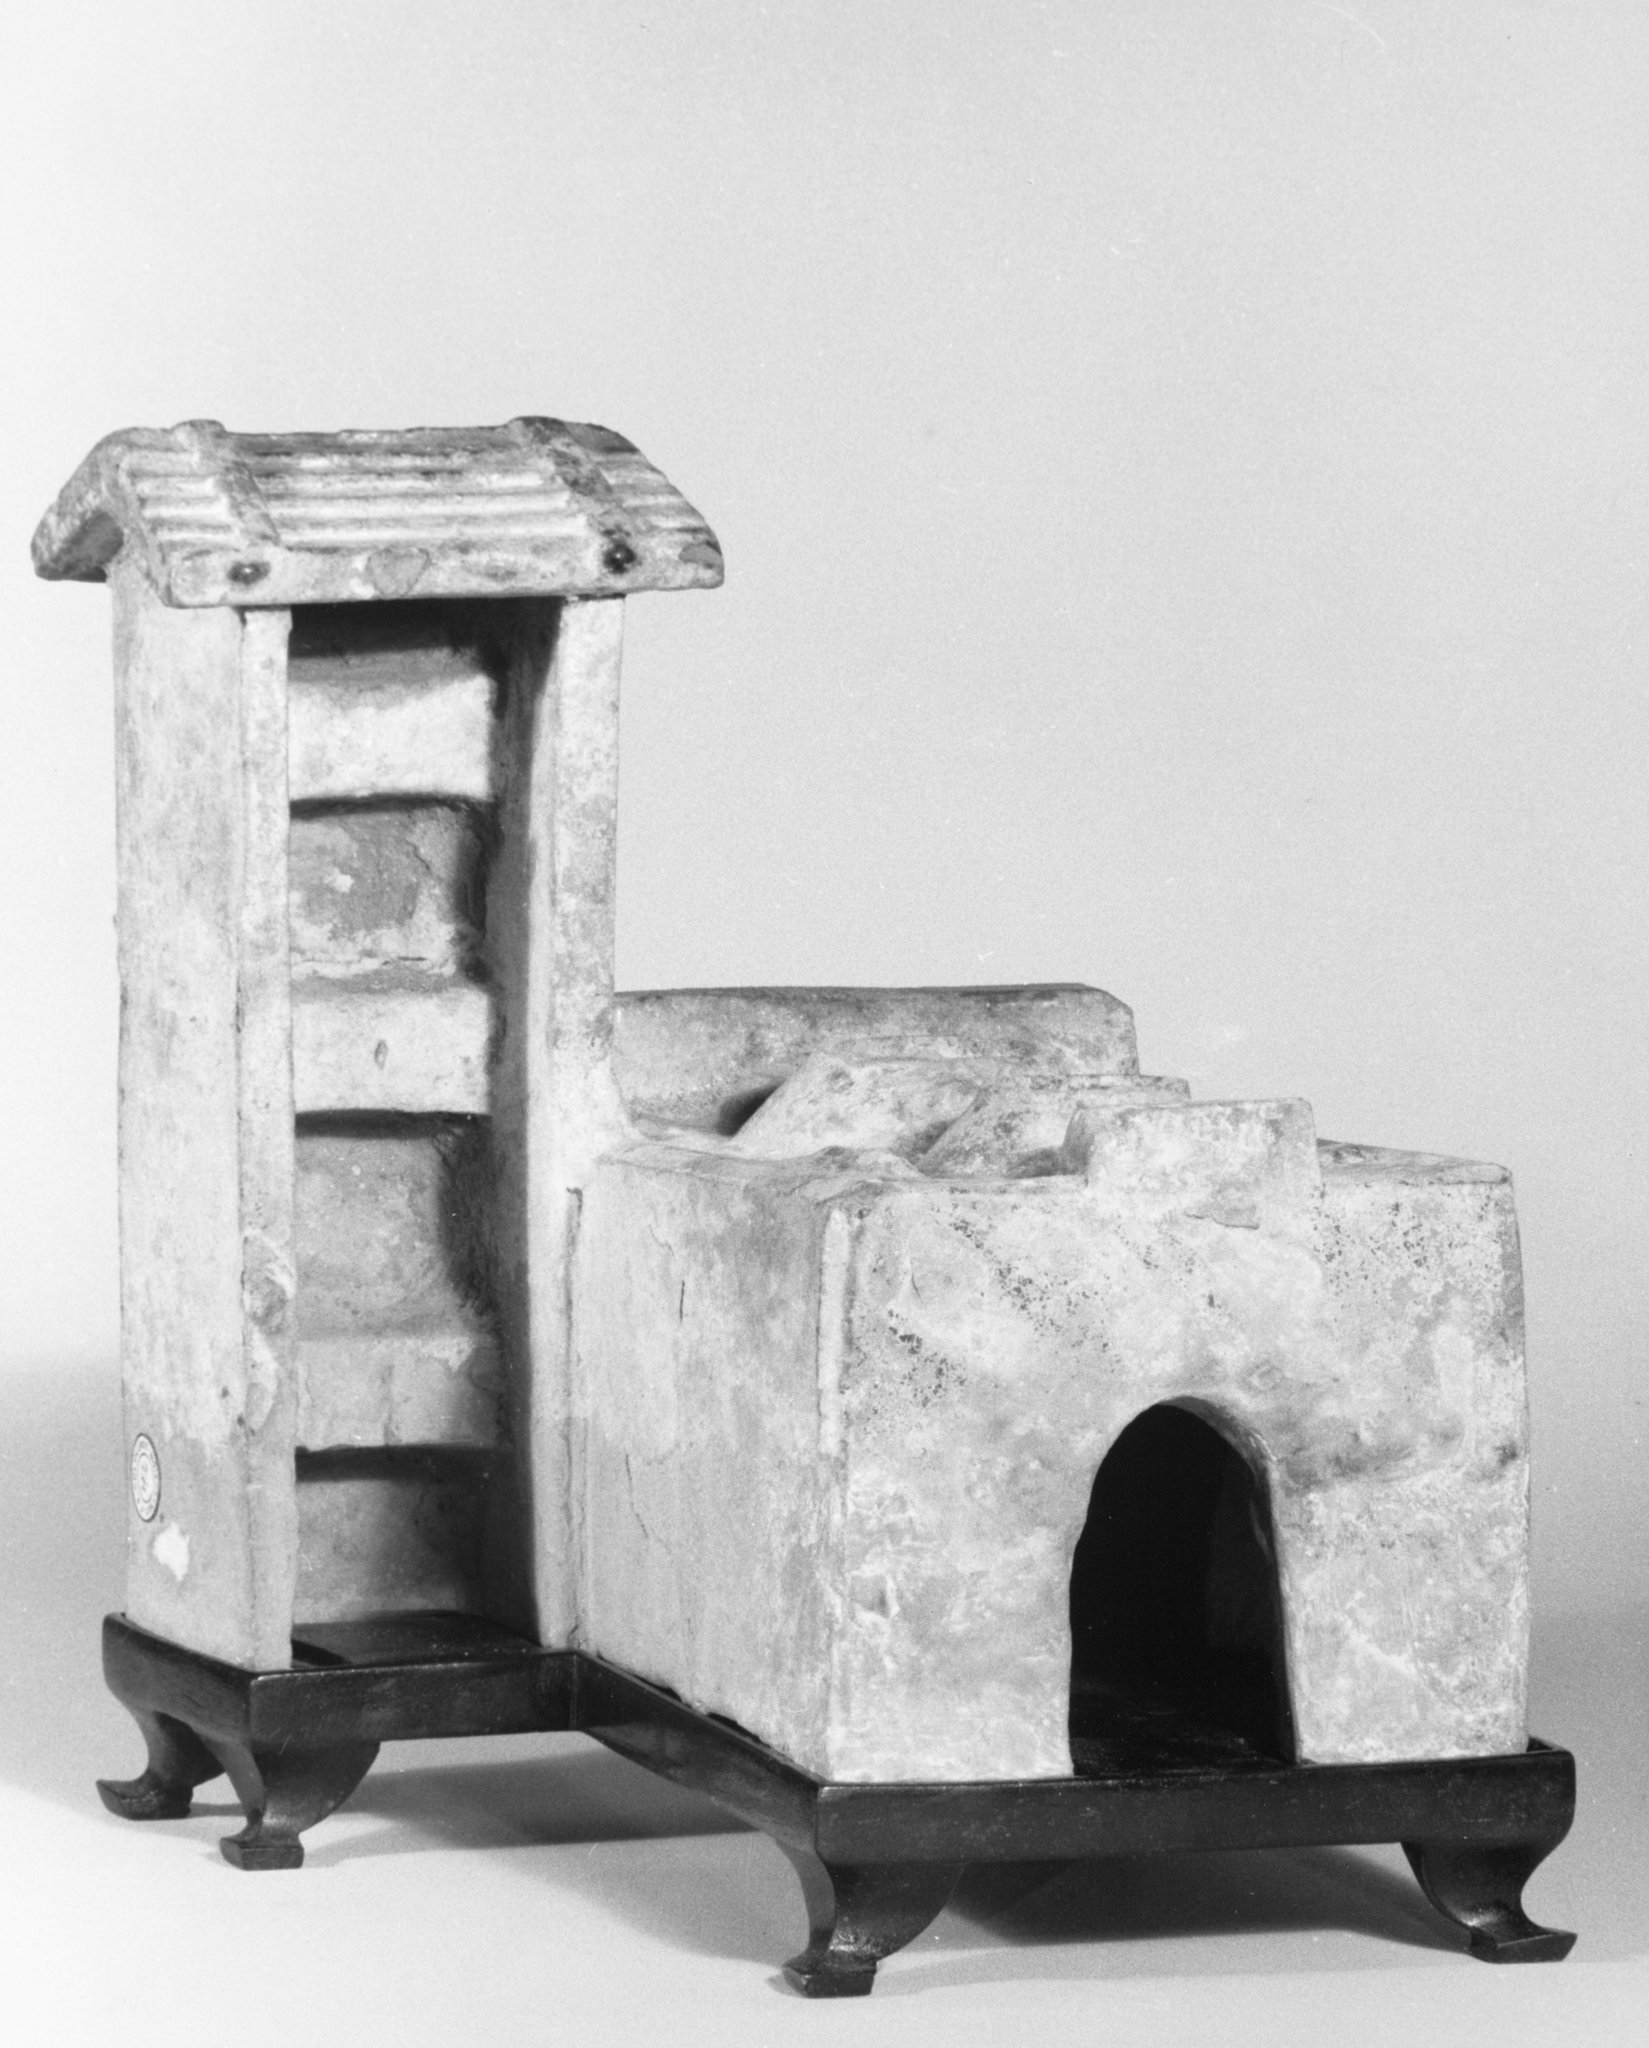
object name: stove model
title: Stove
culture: chinese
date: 1-233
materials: earthenware, glaze